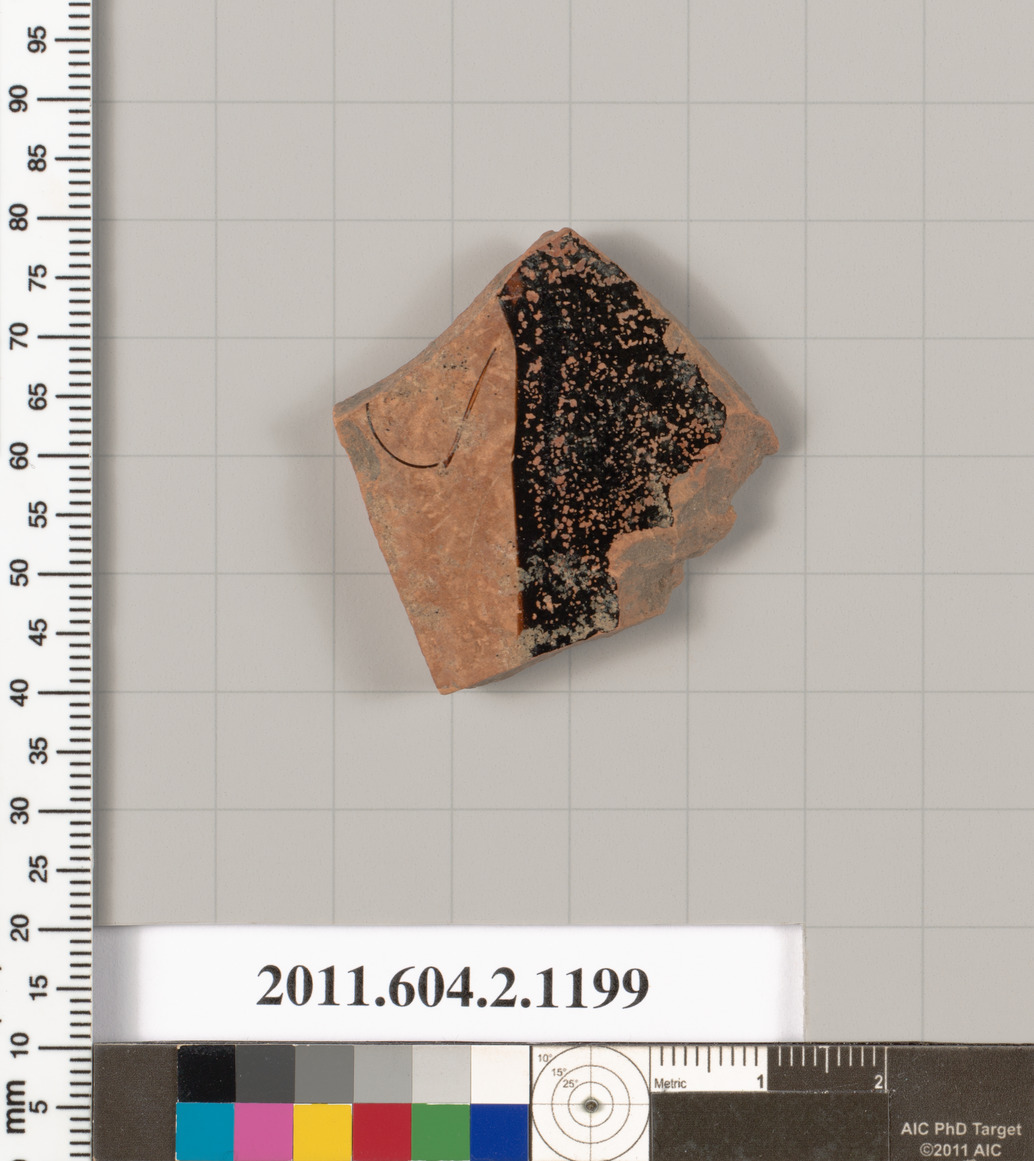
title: Terracotta fragment from an open shape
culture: greek, attic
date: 450-401 BCE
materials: terracotta